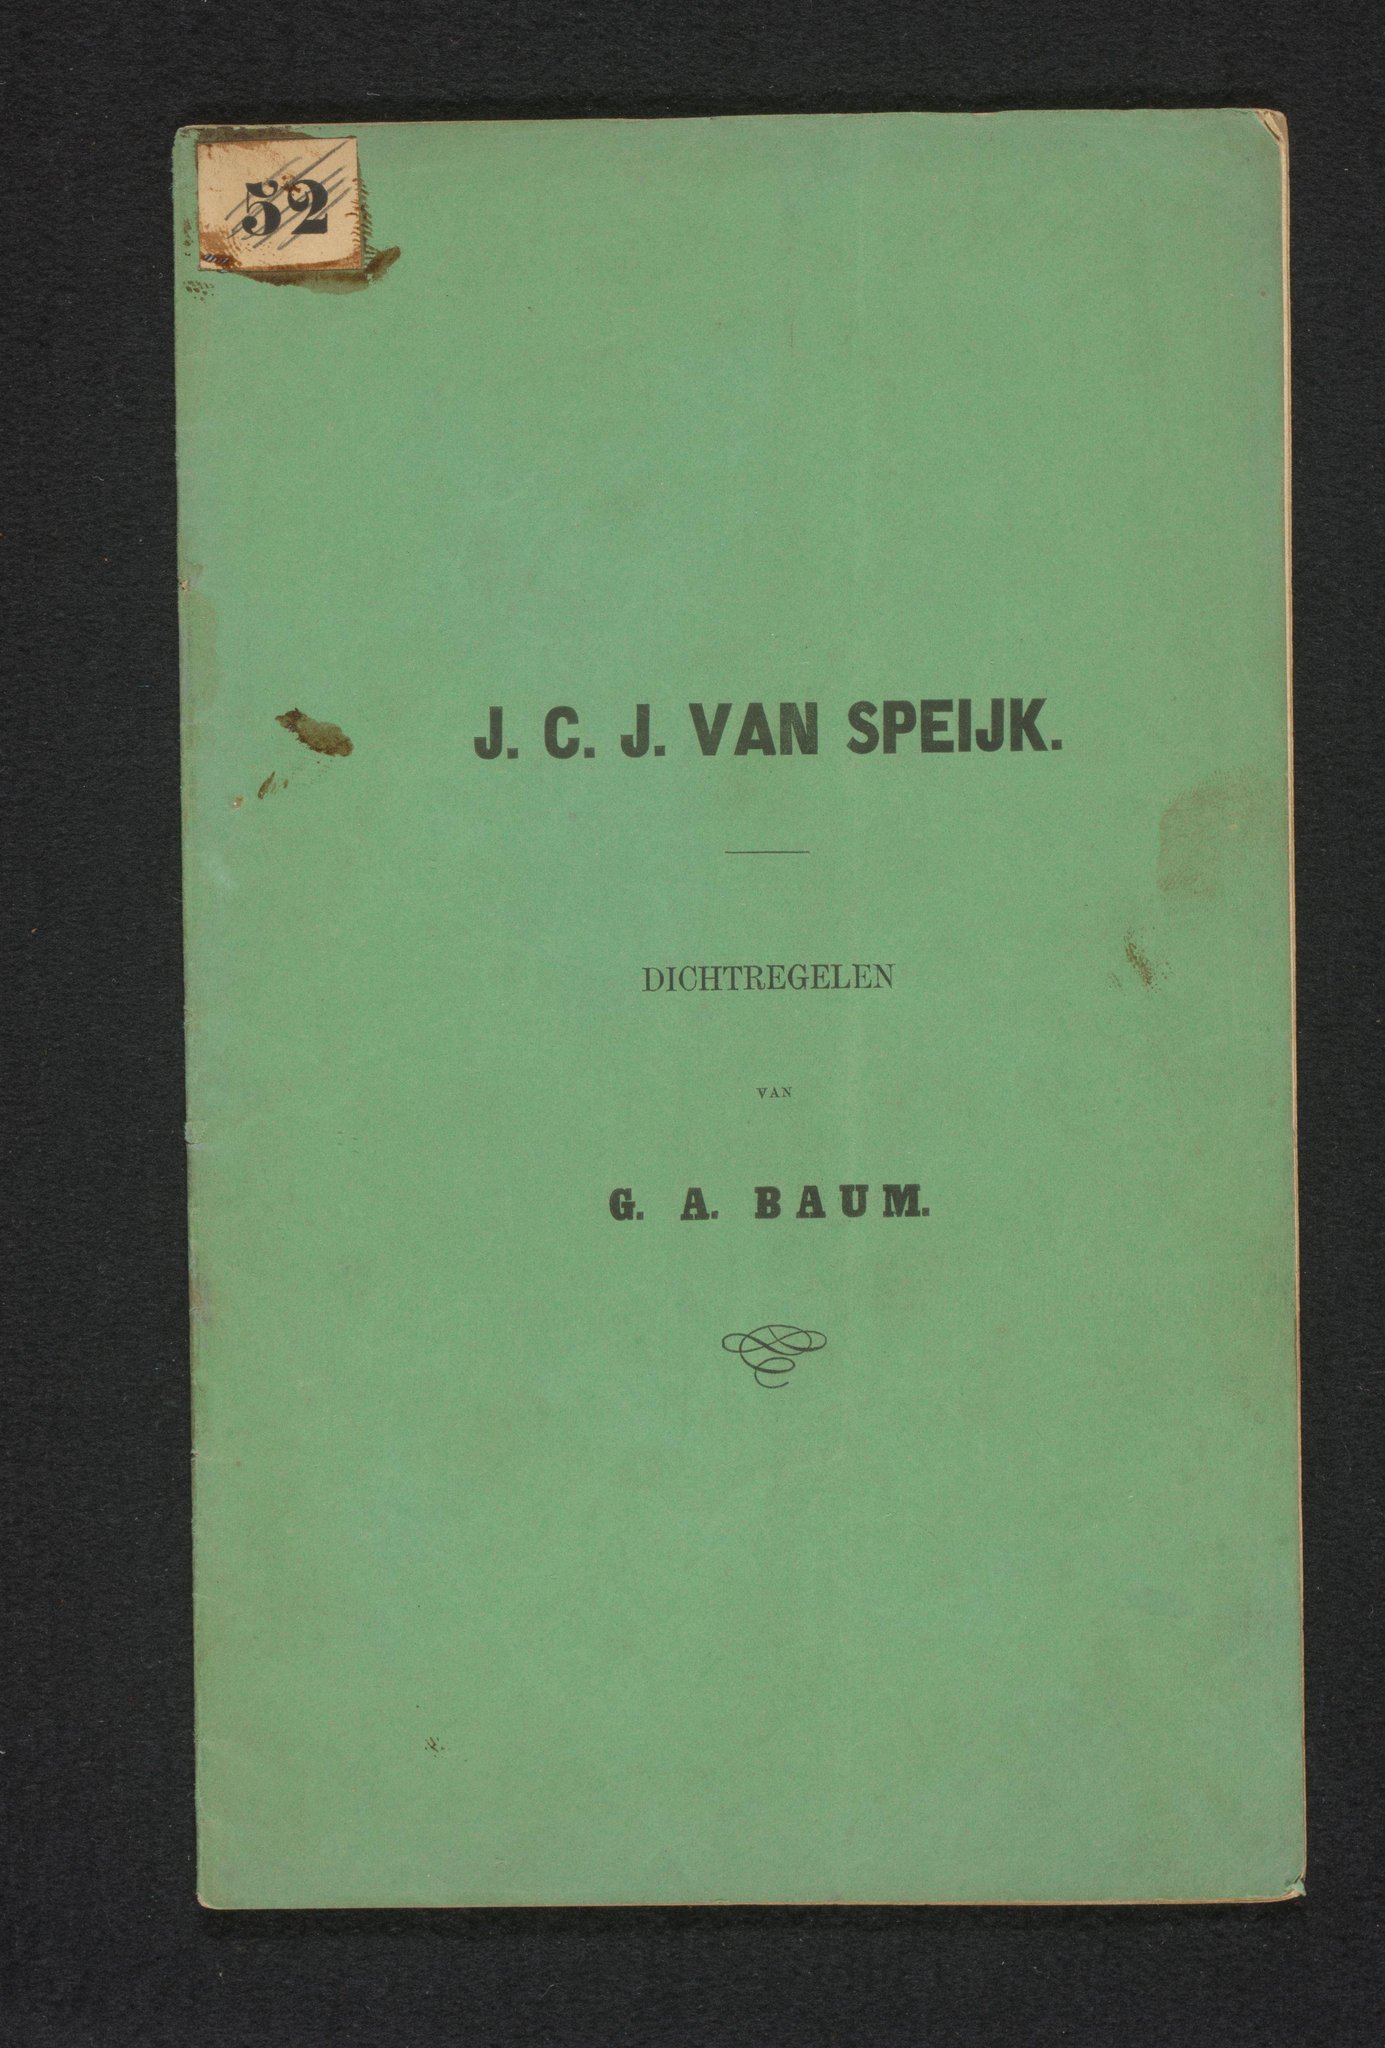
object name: brochure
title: J. C. J. van Speyk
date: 1831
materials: paper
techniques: printing, sewing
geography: utrecht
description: 14 genummerde pp in groene papieren omslag.